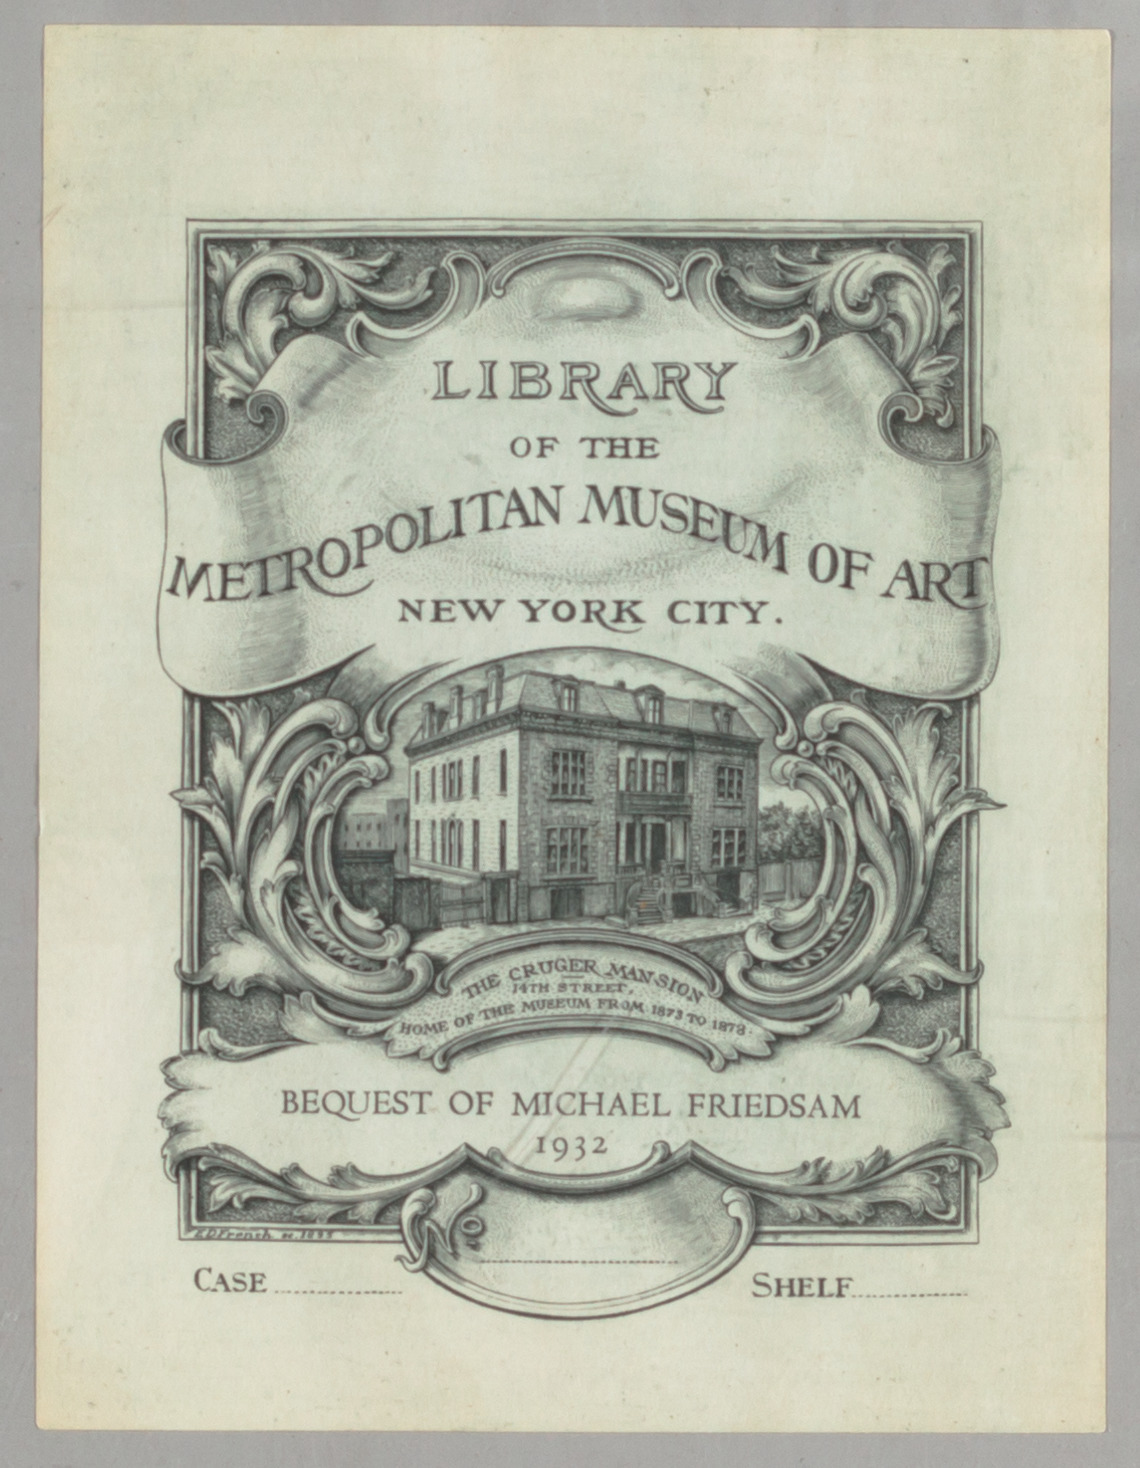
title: Library of the Metropolitan Museum of Art bookplate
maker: edwin davis french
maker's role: engraver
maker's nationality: american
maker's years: 1851-1906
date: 1895